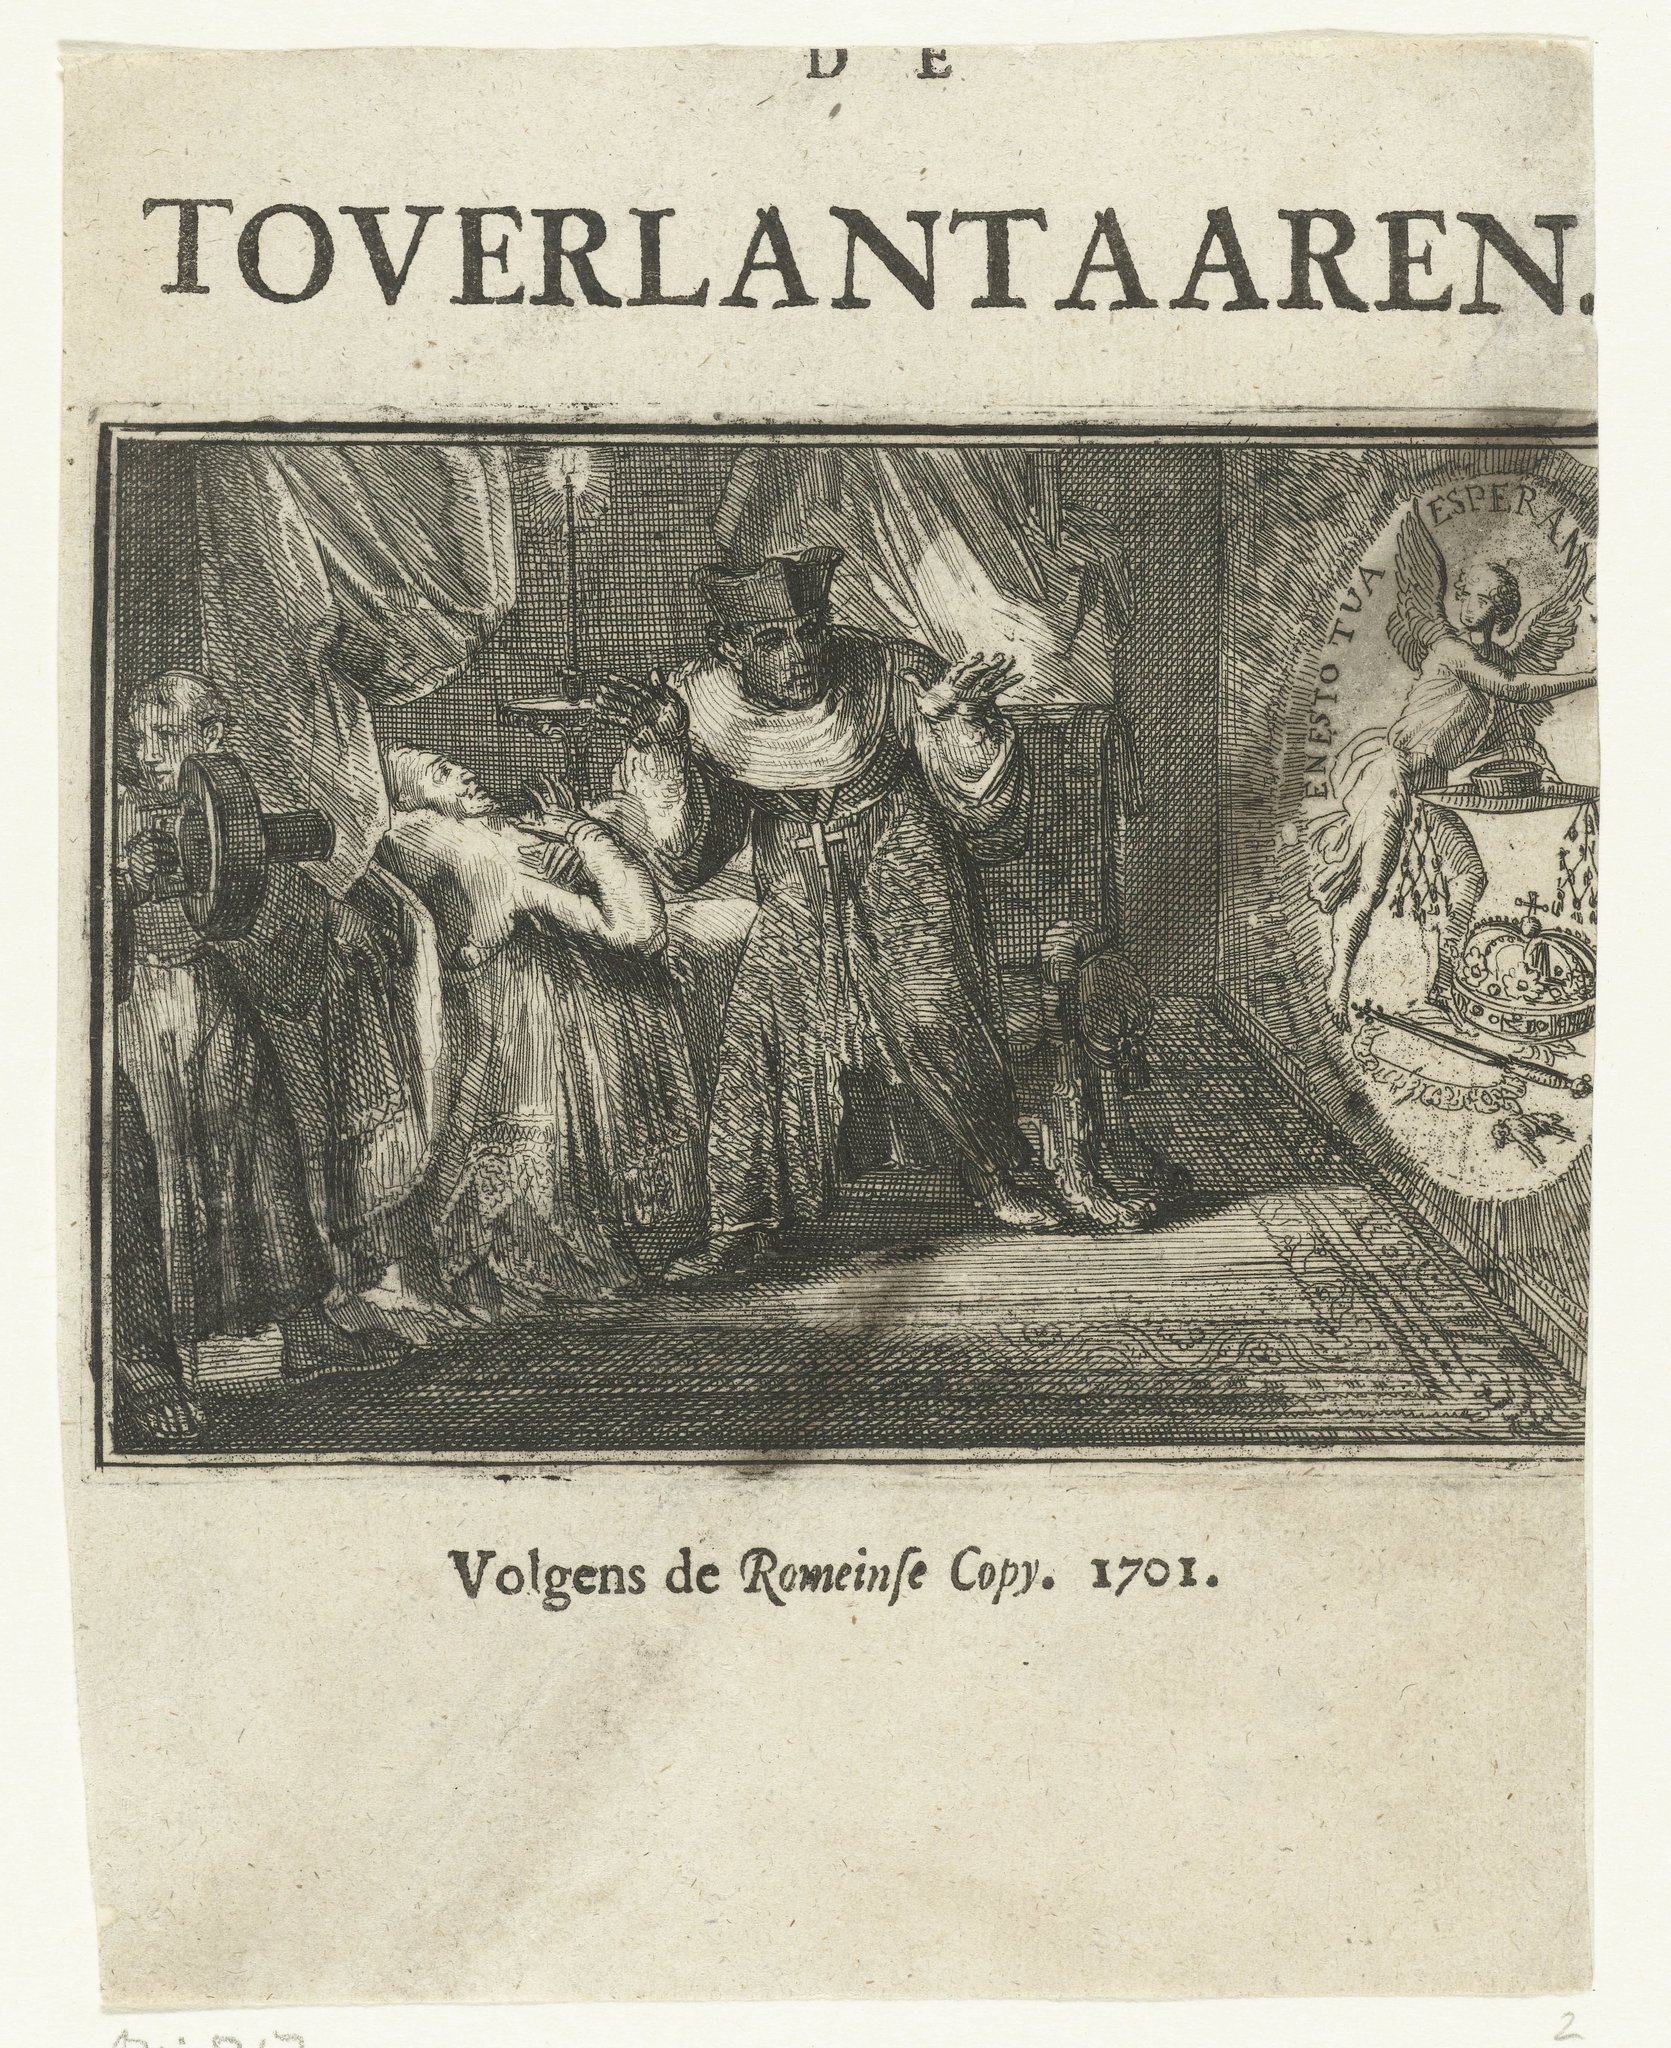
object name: print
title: De Toverlantaaren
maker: romeyn de hooghe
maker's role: draughtsman, goldsmith, painter, print maker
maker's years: 1645-1708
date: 1701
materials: paper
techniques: etching, letterpress printing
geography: northern netherlands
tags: karel ii (koning van spanje), transparency, slide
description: Titelblad voor het pamflet: De Toverlantaaren, 1701. In de slaapkamer van de stervende Spaanse koning Karel II projecteren twee jezuïeten een allegorische afbeelding met een toverlantaarn op de muur.